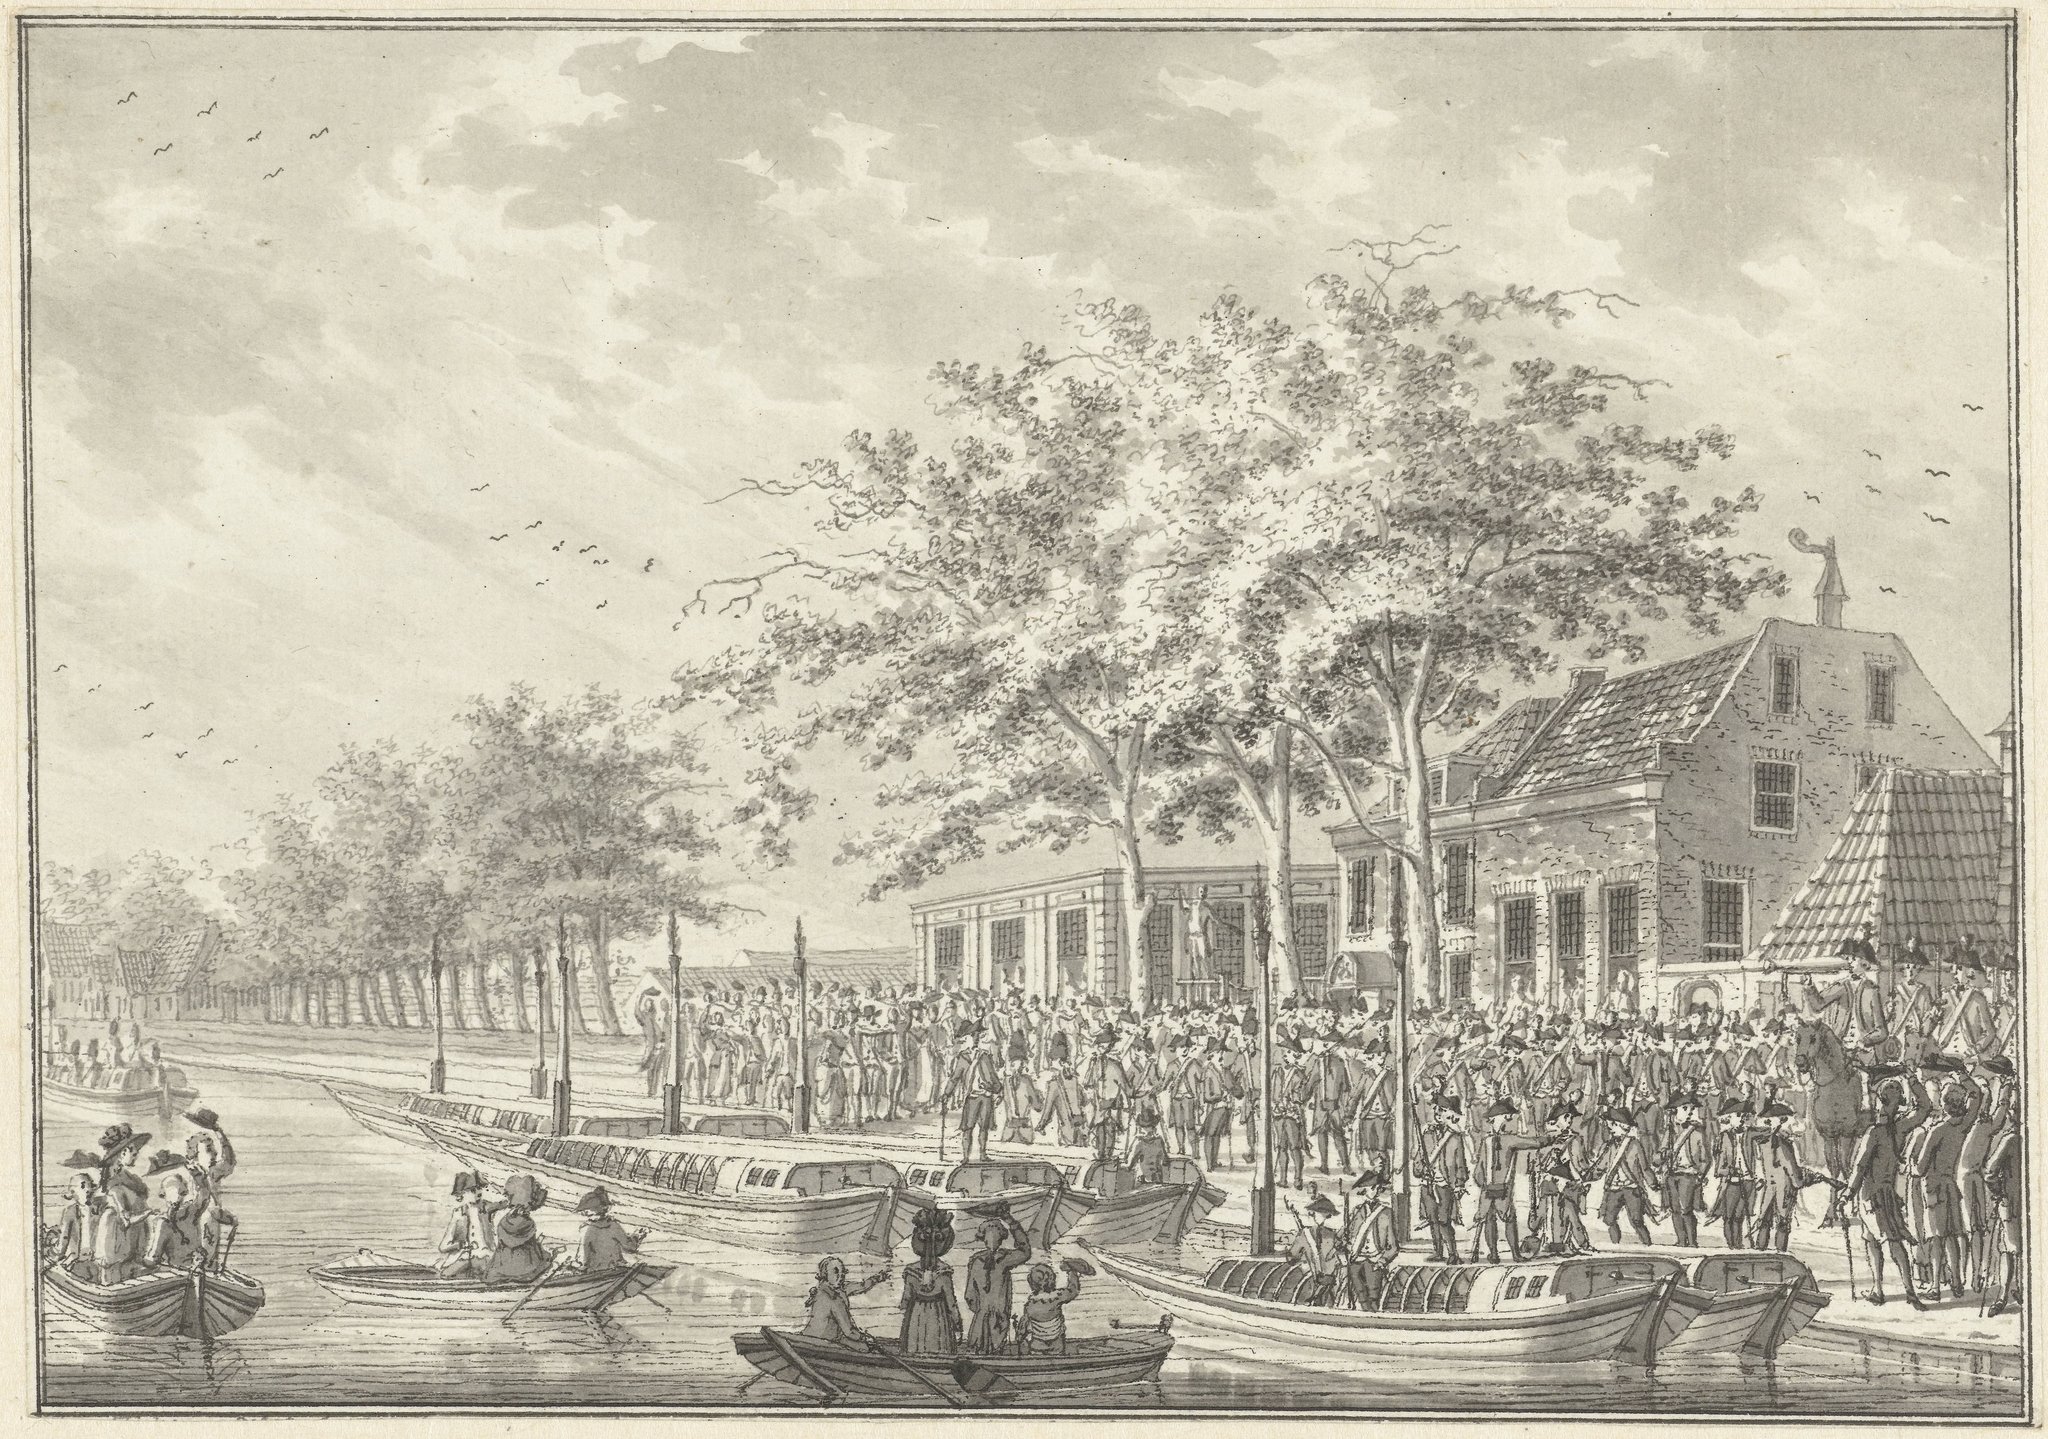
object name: design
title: Vertrek van de Amsterdammers naar Utrecht, 1787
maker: daniël kerkhoff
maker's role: draughtsman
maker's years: 1766-1821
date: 1787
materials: ink, paper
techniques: brush, pen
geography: northern netherlands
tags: waving farewell ~ departure on a journey (+ propulsion of vehicle, ship, etc. by ...)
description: Gezicht op de herberg Berebijt aan de Amstel van waar schuiten met de 600 gewapende Amsterdamse burgers inschepen en vertrekken naar Utrecht, 17 juli 1787. Pendant van de tekening met de aankomst te Utrecht. Ontwerp voor een prent.